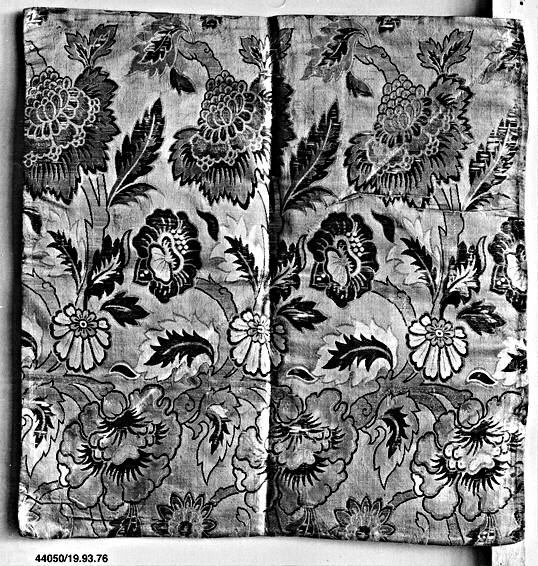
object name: altar cloth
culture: japanese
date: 1615-1868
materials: metal thread, silk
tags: flowers